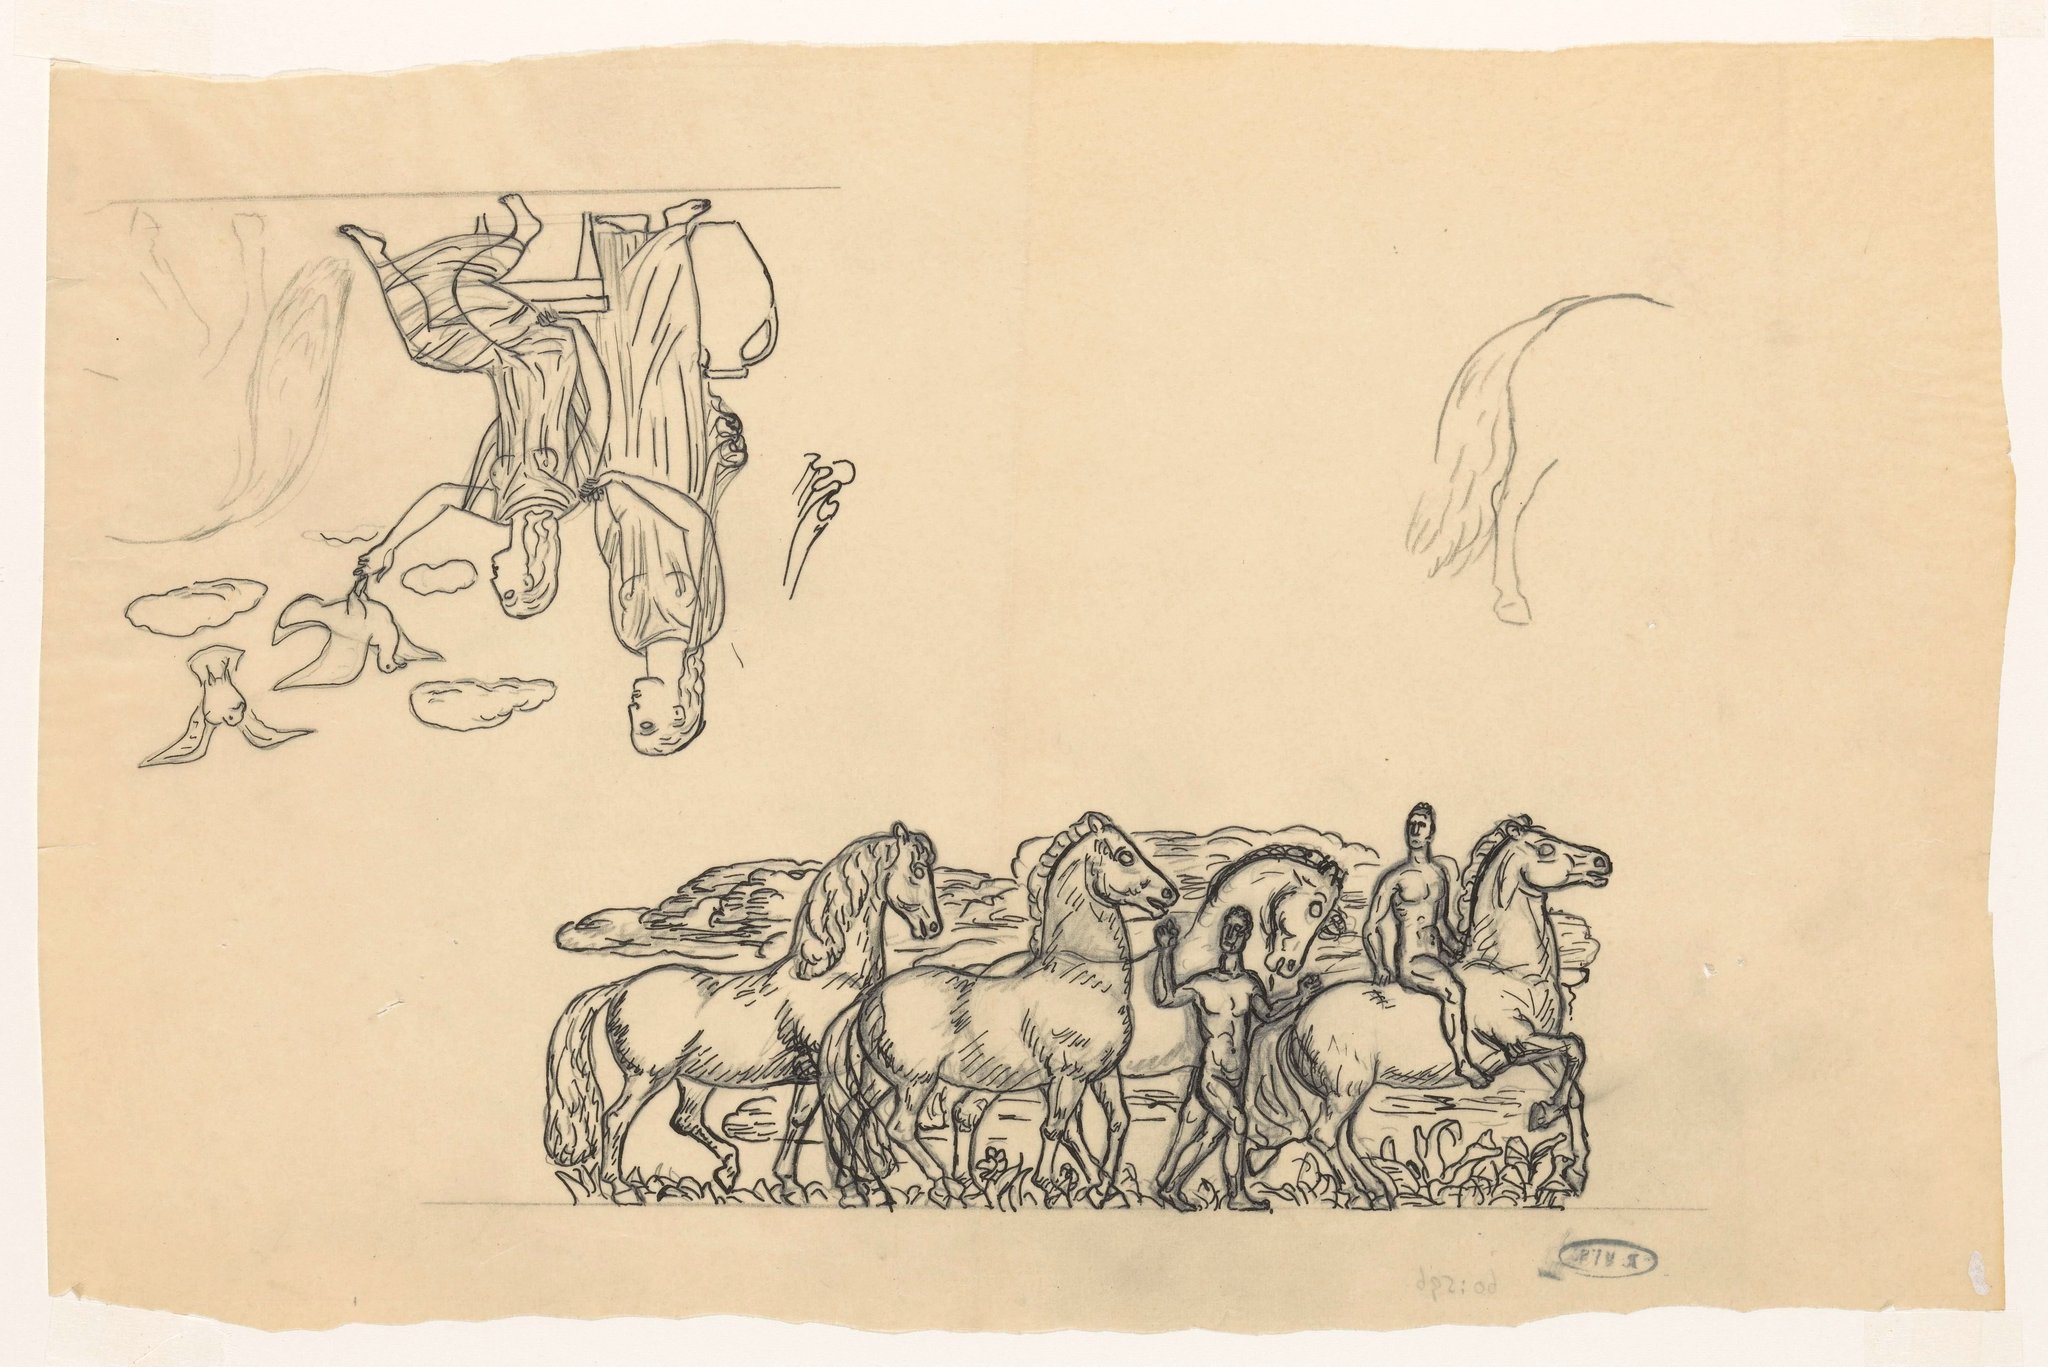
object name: drawing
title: Studieblad met twee mannen met paarden en twee vrouwen met duiven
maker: leo gestel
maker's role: draughtsman, print maker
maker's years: 1881-1941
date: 1891-1941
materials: ink, pencil, paper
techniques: pen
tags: other birds: dove, female sex; woman, horse, male sex; man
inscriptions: collector's mark: Lugt 2228